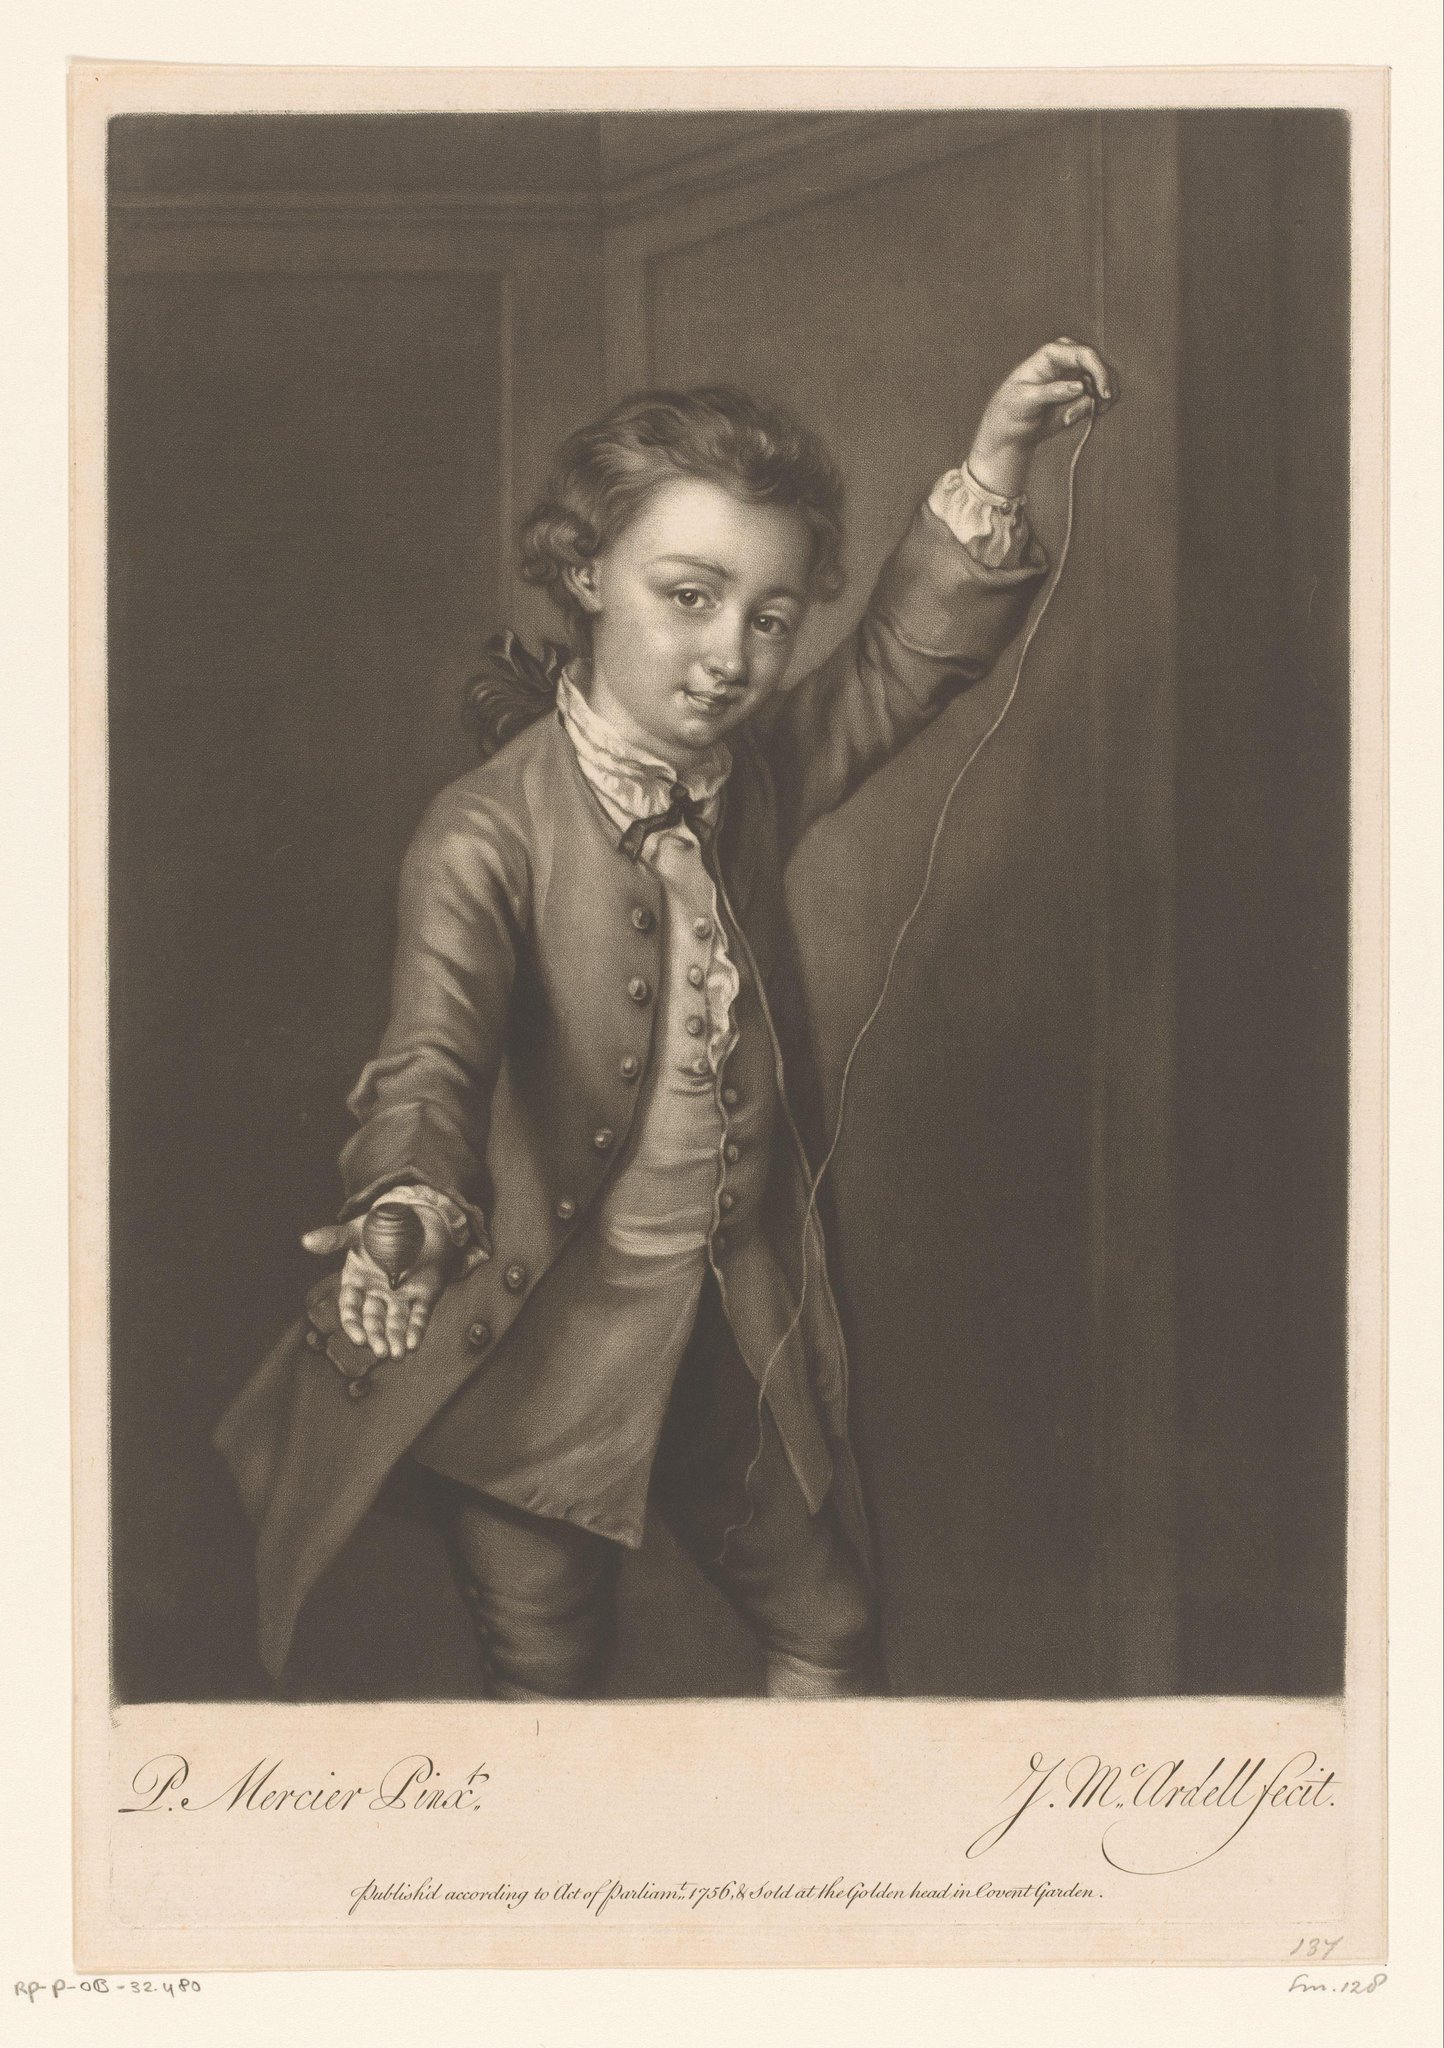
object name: print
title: Portret van Philip Mercier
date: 1756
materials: paper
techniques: mezzotint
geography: london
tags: historical persons, spinning a top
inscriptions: collector's mark: Lugt 240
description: Portret van de zoon van Philippe Mercier spelend met een tol.